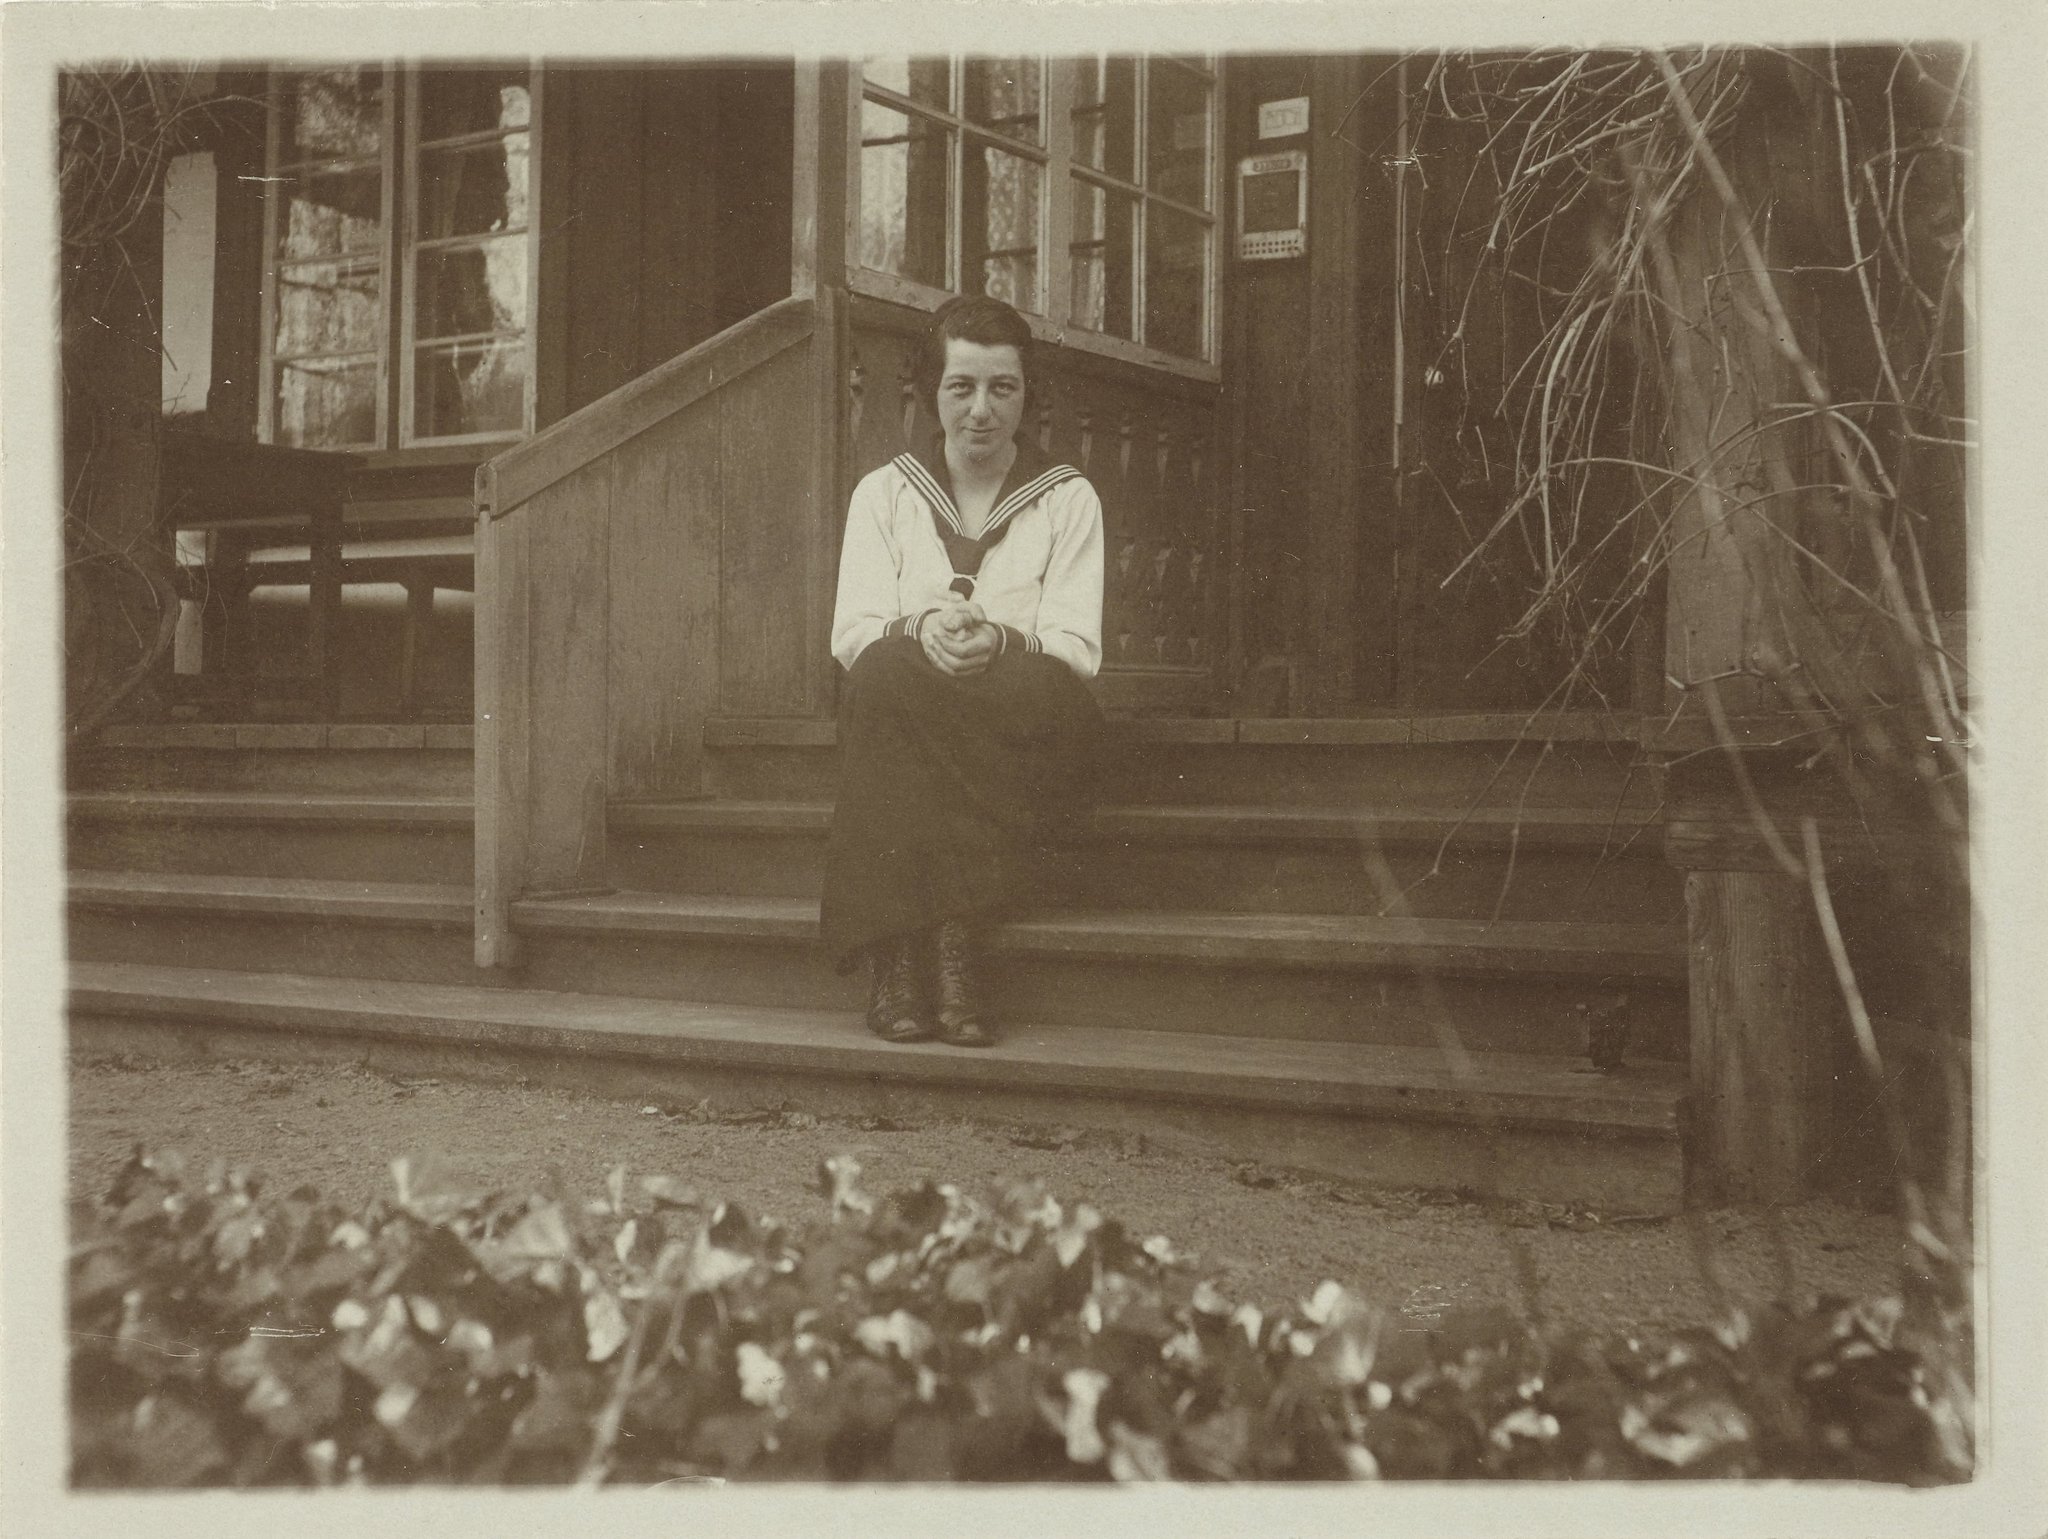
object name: photograph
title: Portret van Irene With zittend op trap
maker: Anonymous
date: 1920-1930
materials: paper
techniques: gelatin silver print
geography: germany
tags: amsterdam, historical persons - bb - woman, ensemble of pieces of clothing: sailor suit, front steps, loggia, verandah, porch, germany